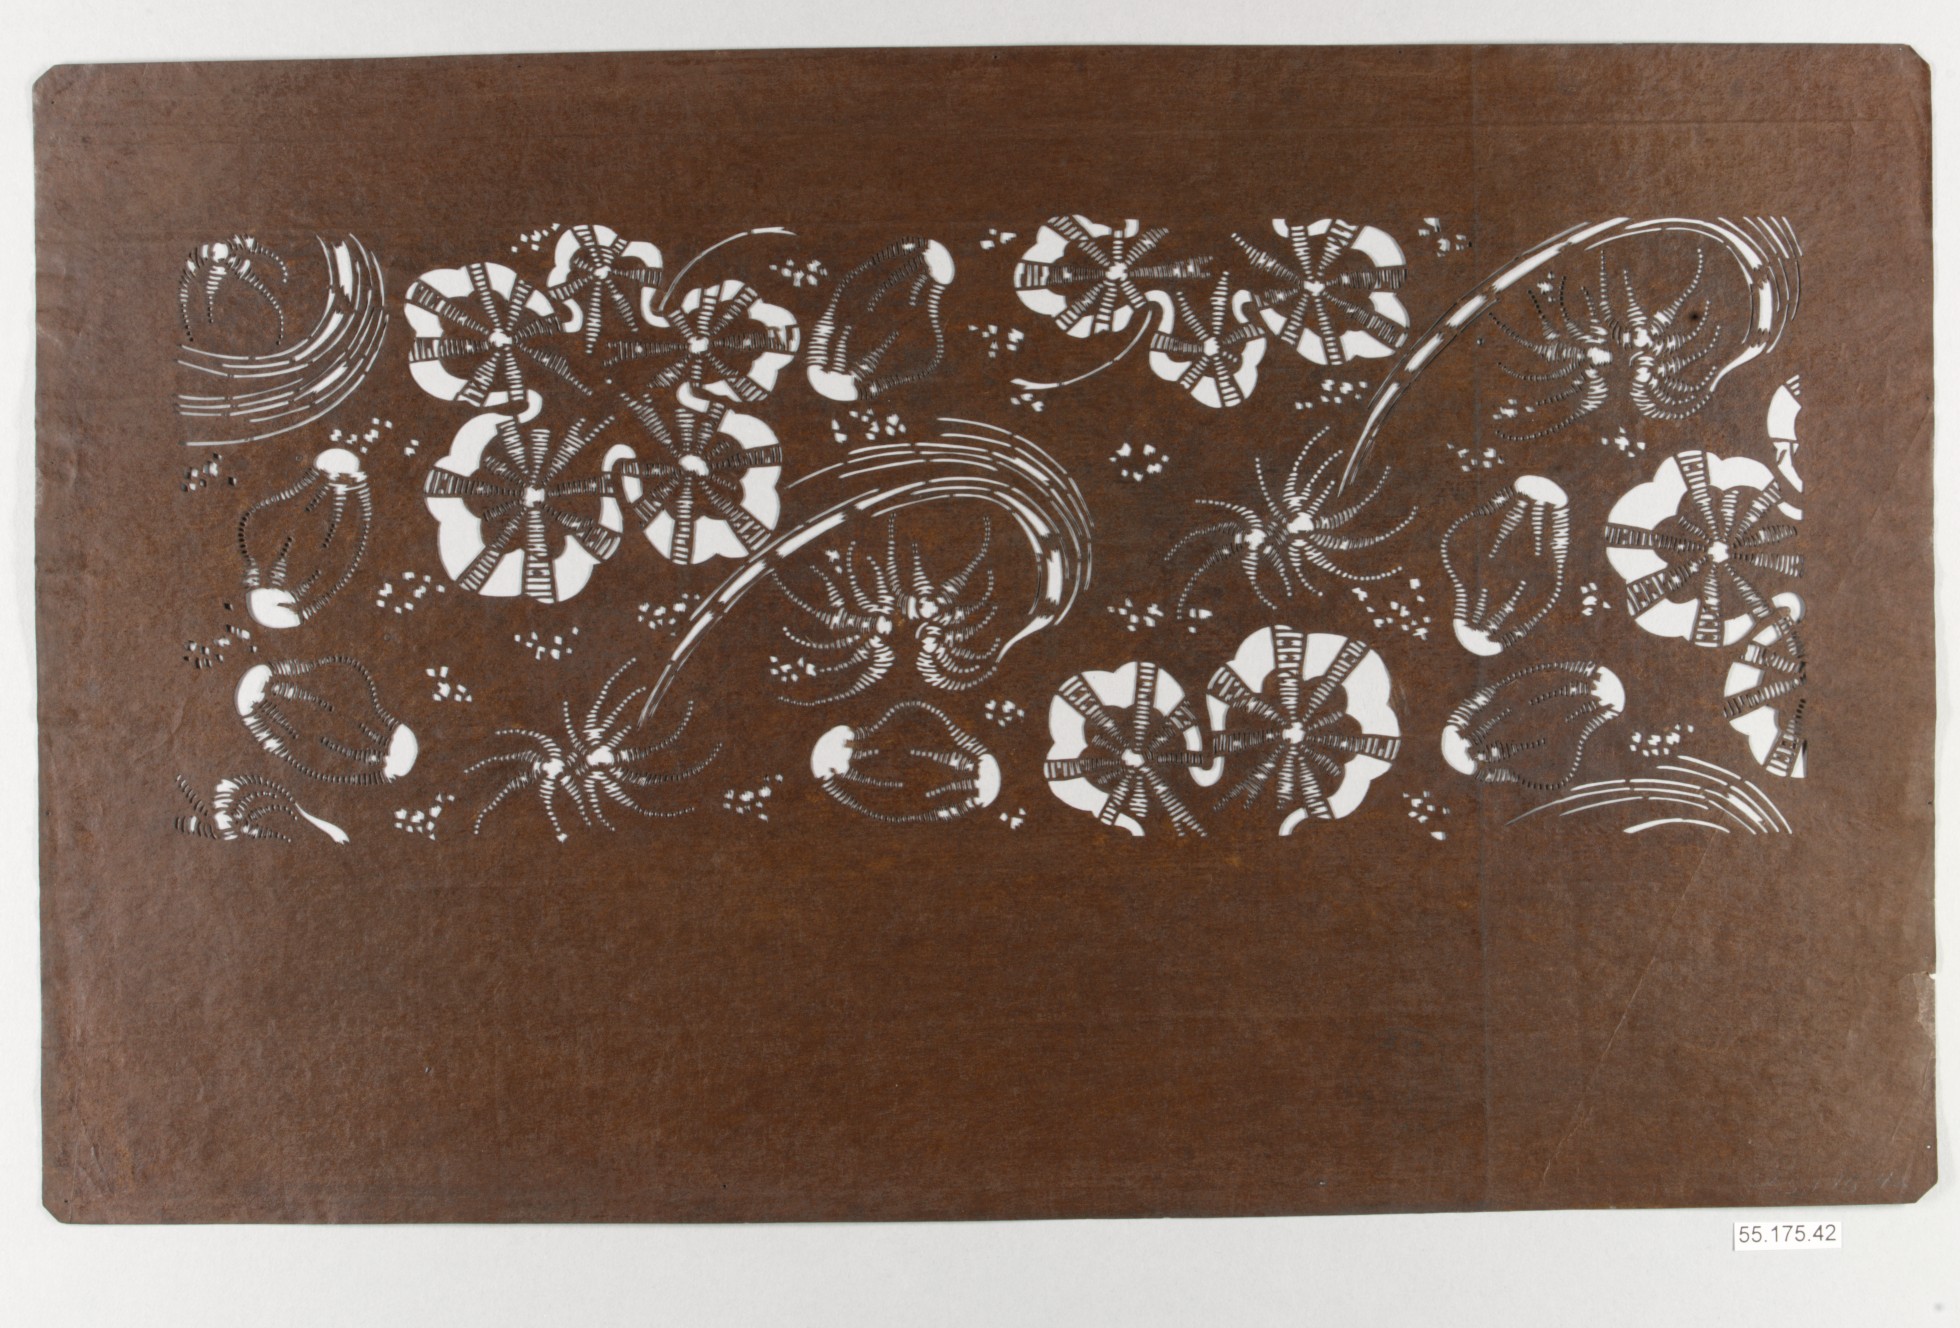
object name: stencil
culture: japanese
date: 1801-1900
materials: paper